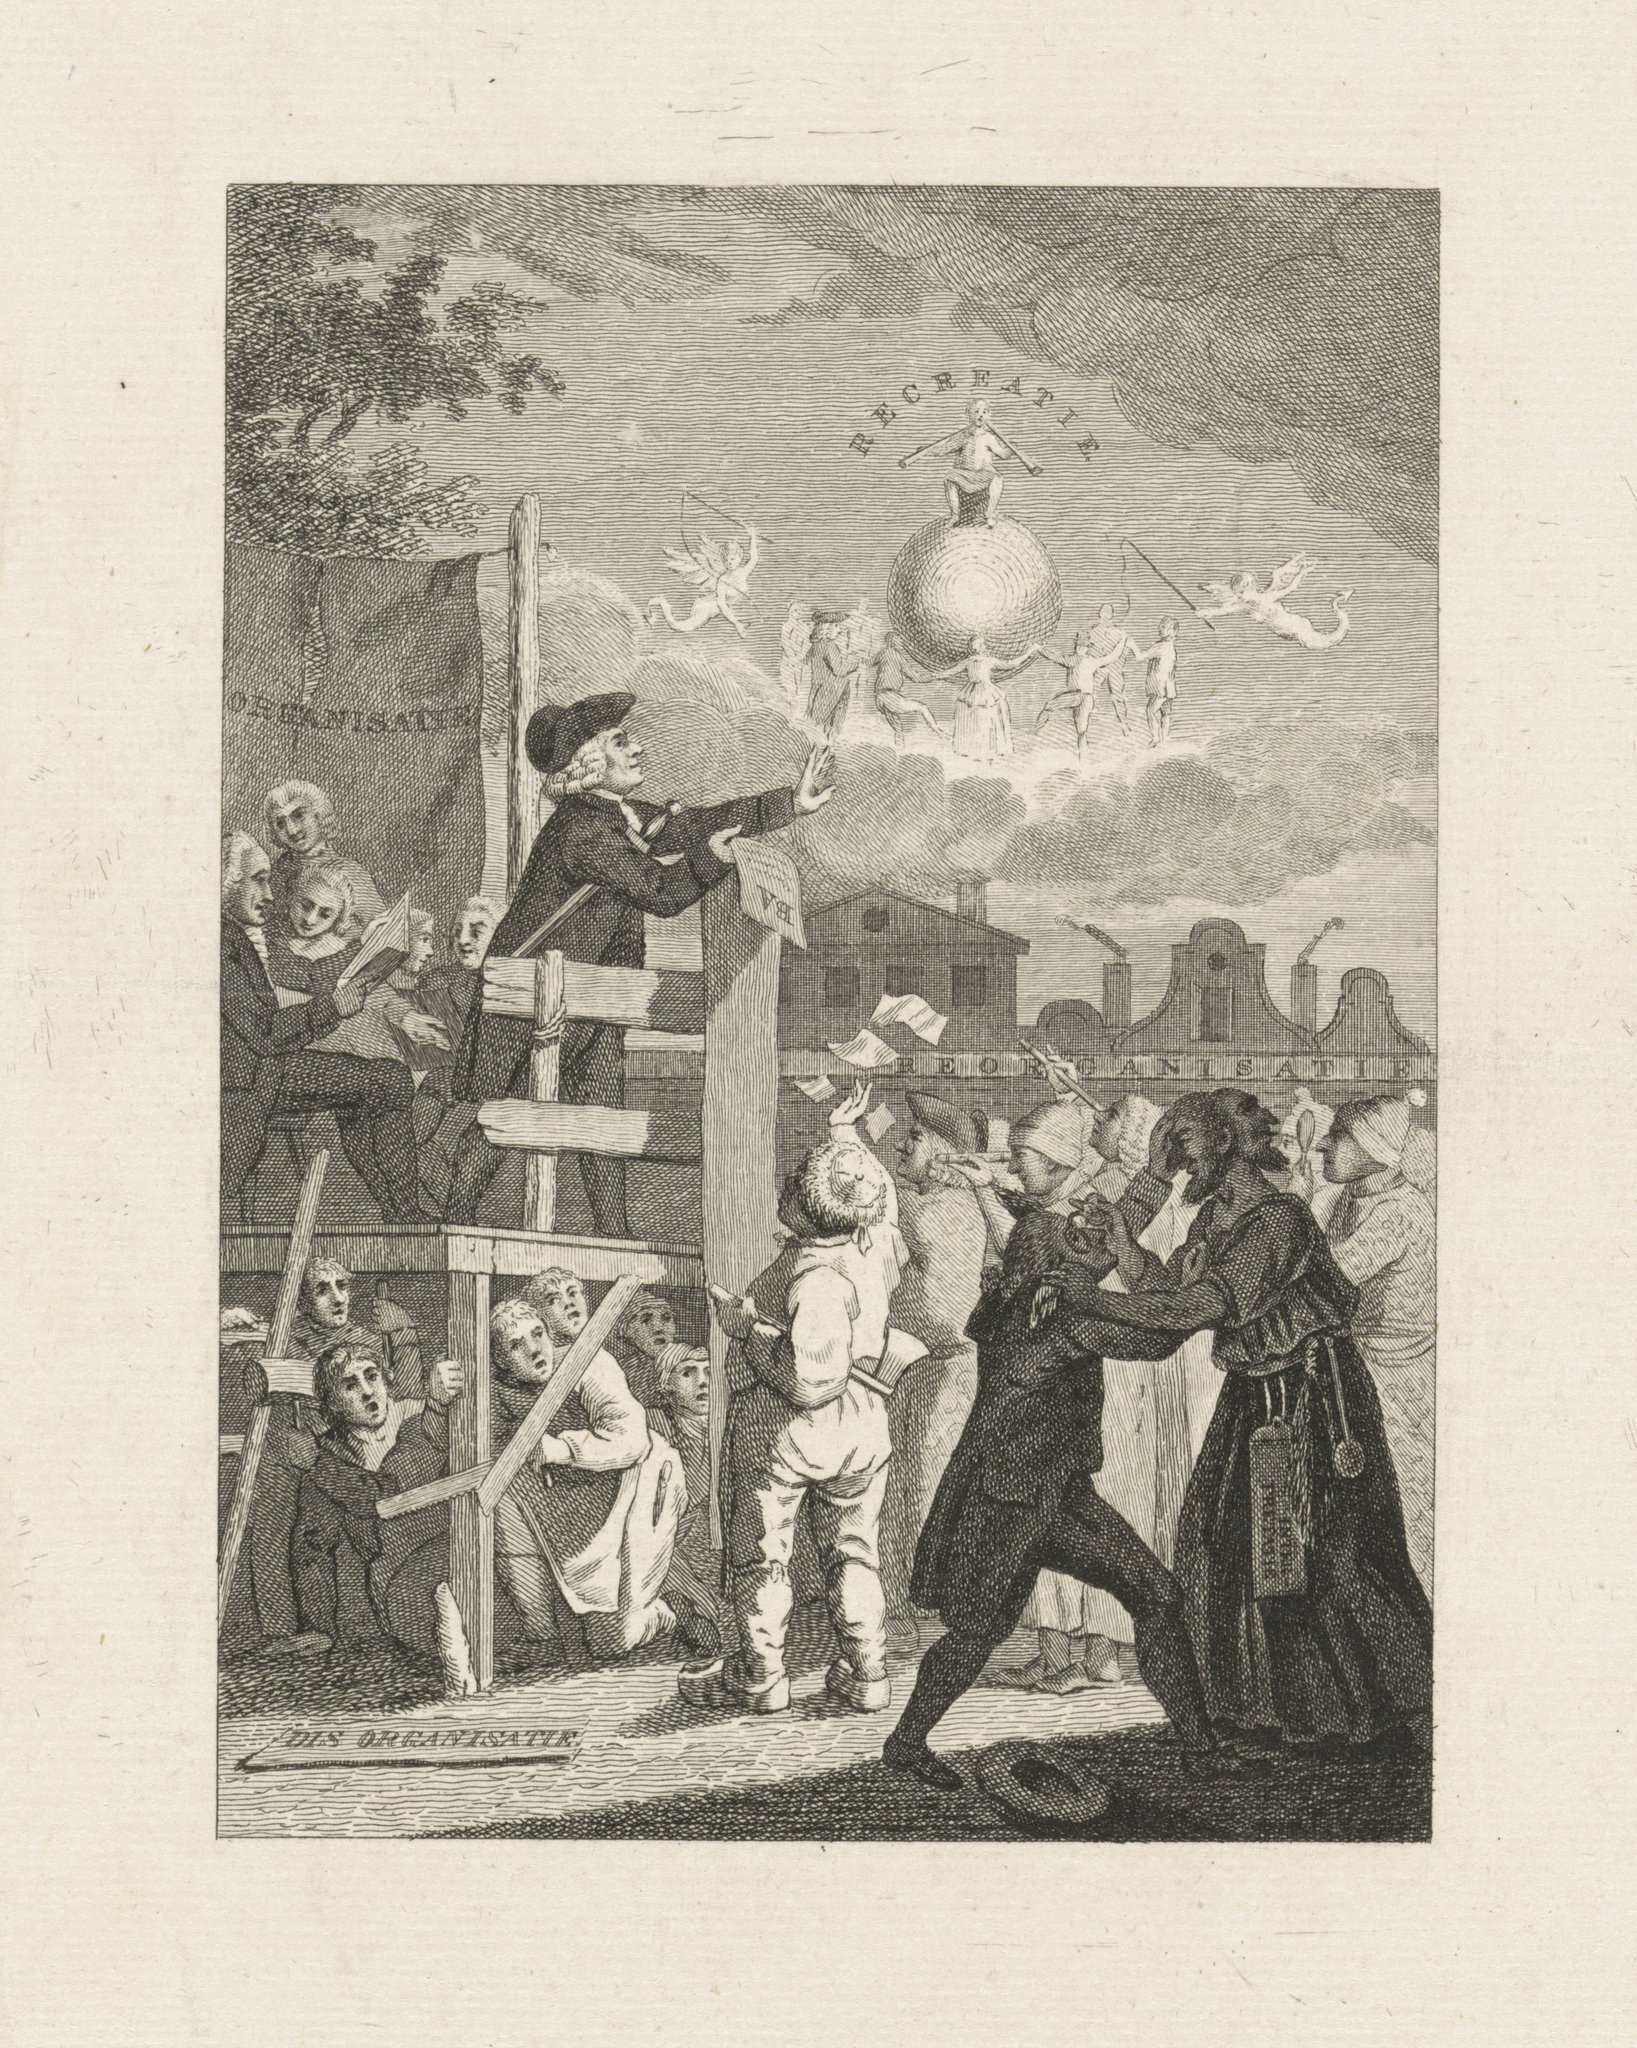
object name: cartoon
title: Organisatie en disorganisatie, 1798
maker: Anonymous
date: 1798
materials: paper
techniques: engraving, etching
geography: netherlands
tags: janus' head, two-faced head, address, talk, lecture (~ meeting) - aa - in the open air, (story of) midas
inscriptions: collector's mark: Lugt 2228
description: Spotprent op de zeer tijdelijke aard van maatregelen van organisatie, terwijl reorganisatie en disorganisatie op de loer liggen, 1798. Een spreker op een stellage spreekt het publiek toe, anderen staan (onder leiding van een scheepstimmerman met bijl) klaar om de poten onder de stellage door te zagen. Rechts op de voorgrond vechten Midas en Janus met elkaar, in de wolken dansen figuren aangezweept door duivels. Waarschijnlijk naar aanleiding van het aannemen van de Staatsregeling op 19 mei 1798.